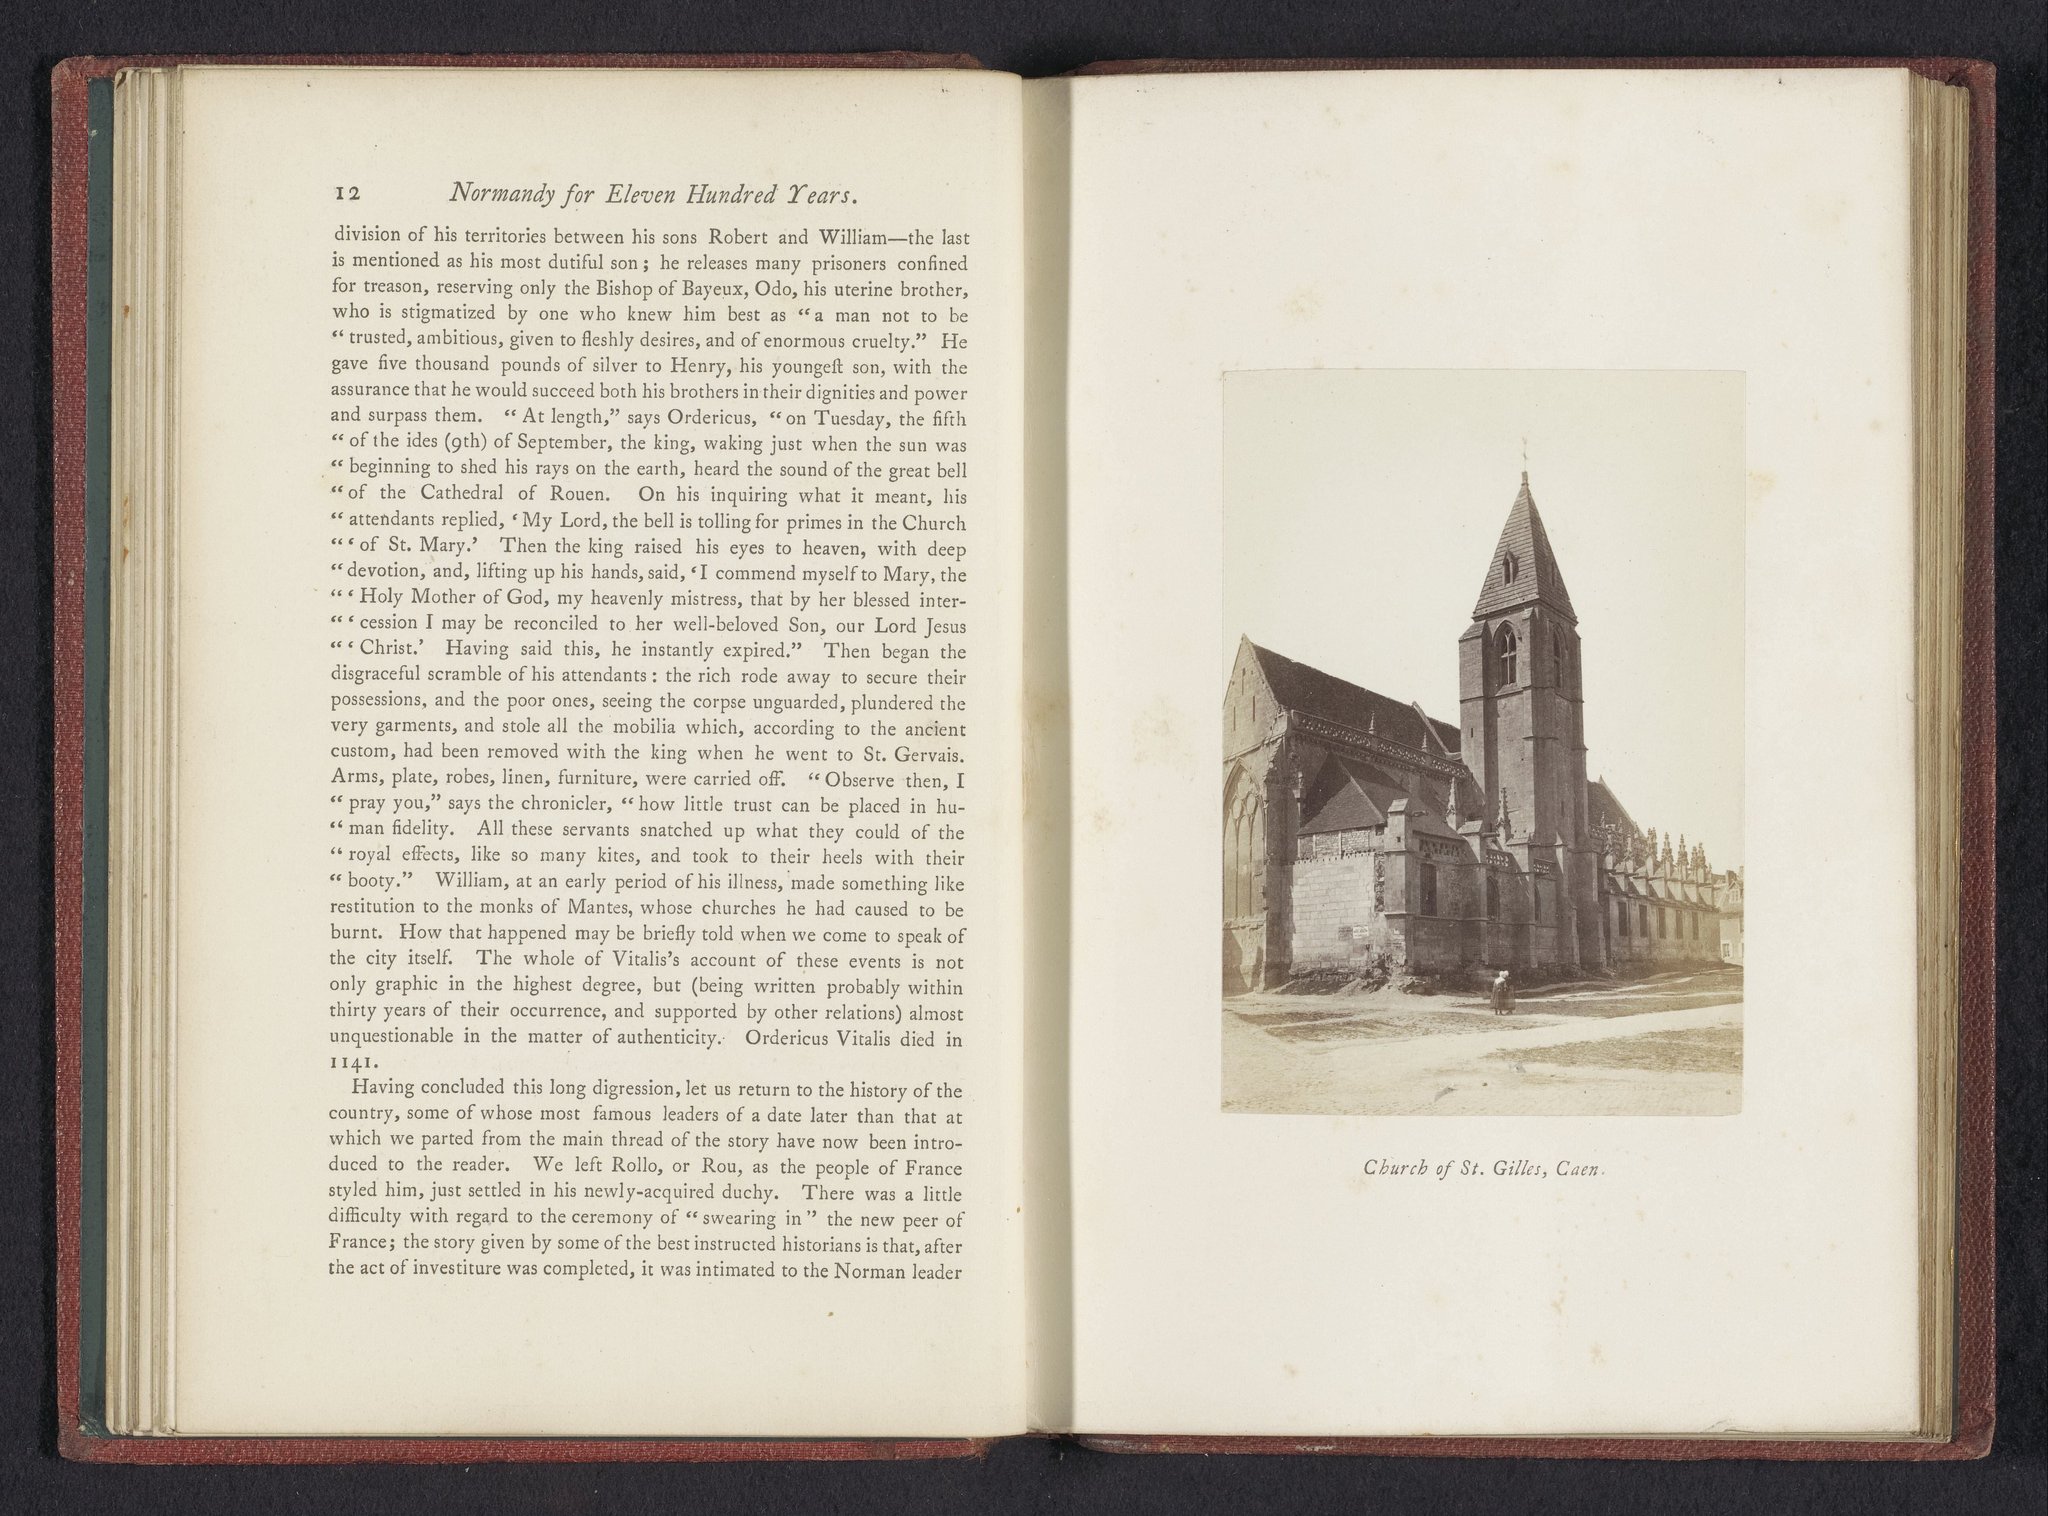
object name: page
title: Church of St. Gilles, Caen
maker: joseph cundall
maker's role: fotograaf, schrijver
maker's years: 1818-1895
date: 1855-1865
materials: photographic support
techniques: albumen print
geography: caen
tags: church (exterior), façade (of house or building)